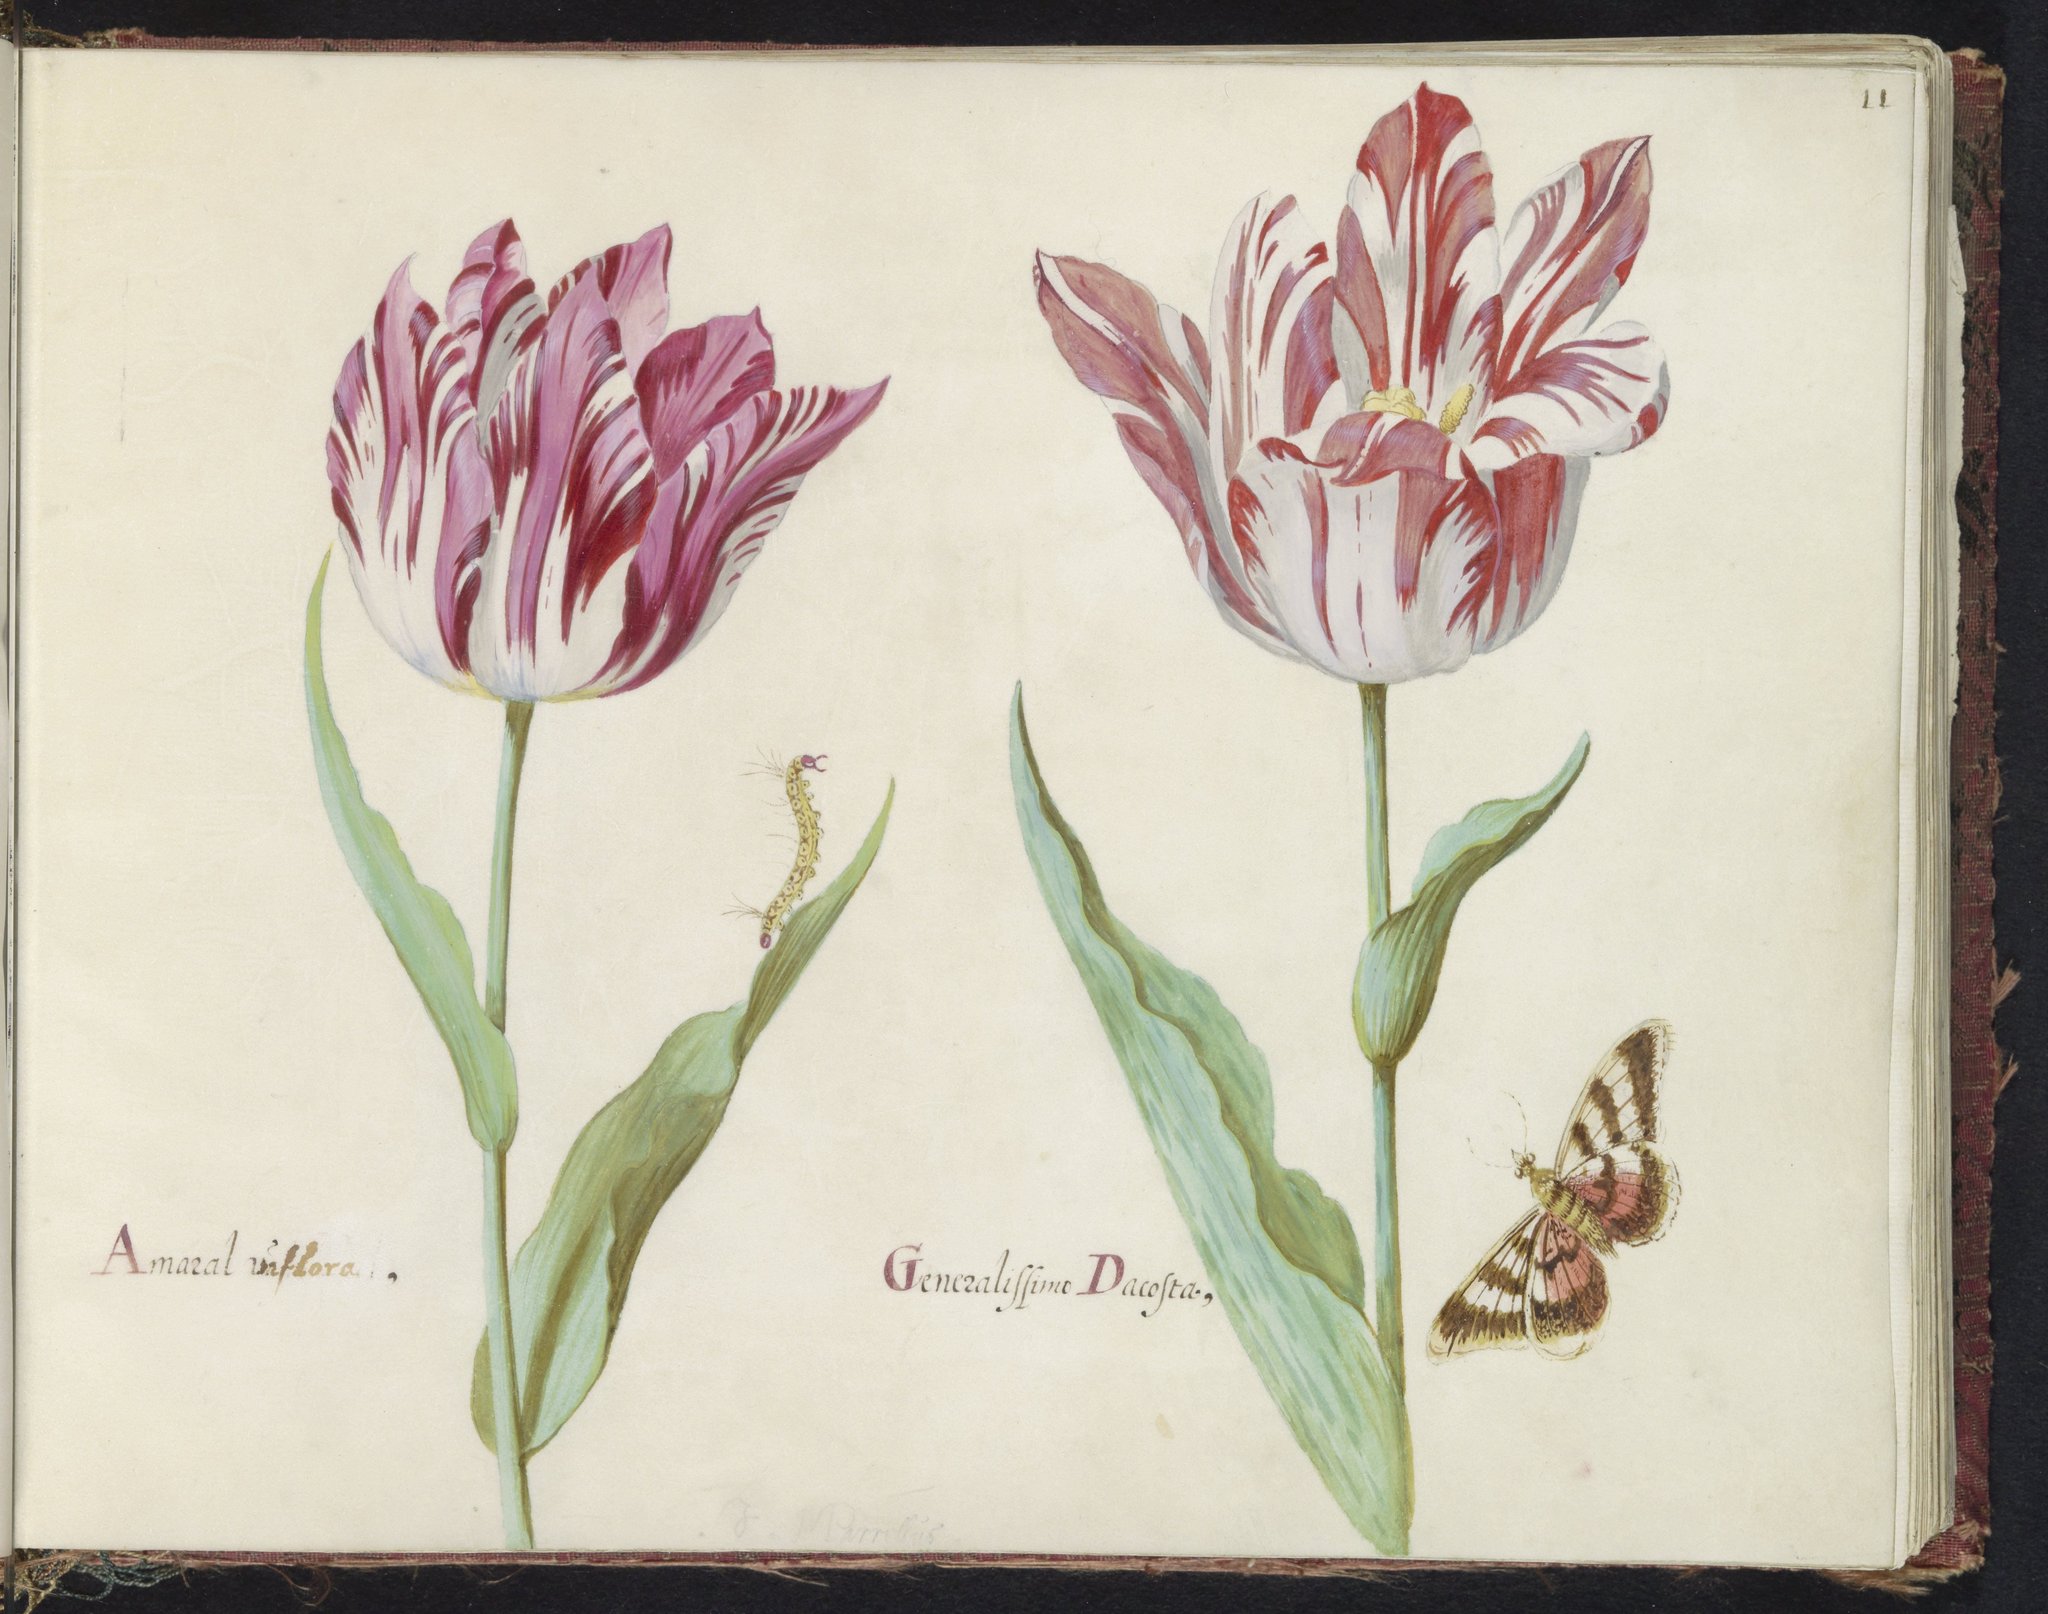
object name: drawing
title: Twee tulpen met rups en vlinder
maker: jacob marrel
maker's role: draughtsman, painter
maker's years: 1614-1681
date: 1637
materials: paint, parchment, pencil, watercolor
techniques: brush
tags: insects: butterfly, flowers: tulip, insects: caterpillar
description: De tekening maakt deel uit van een album.